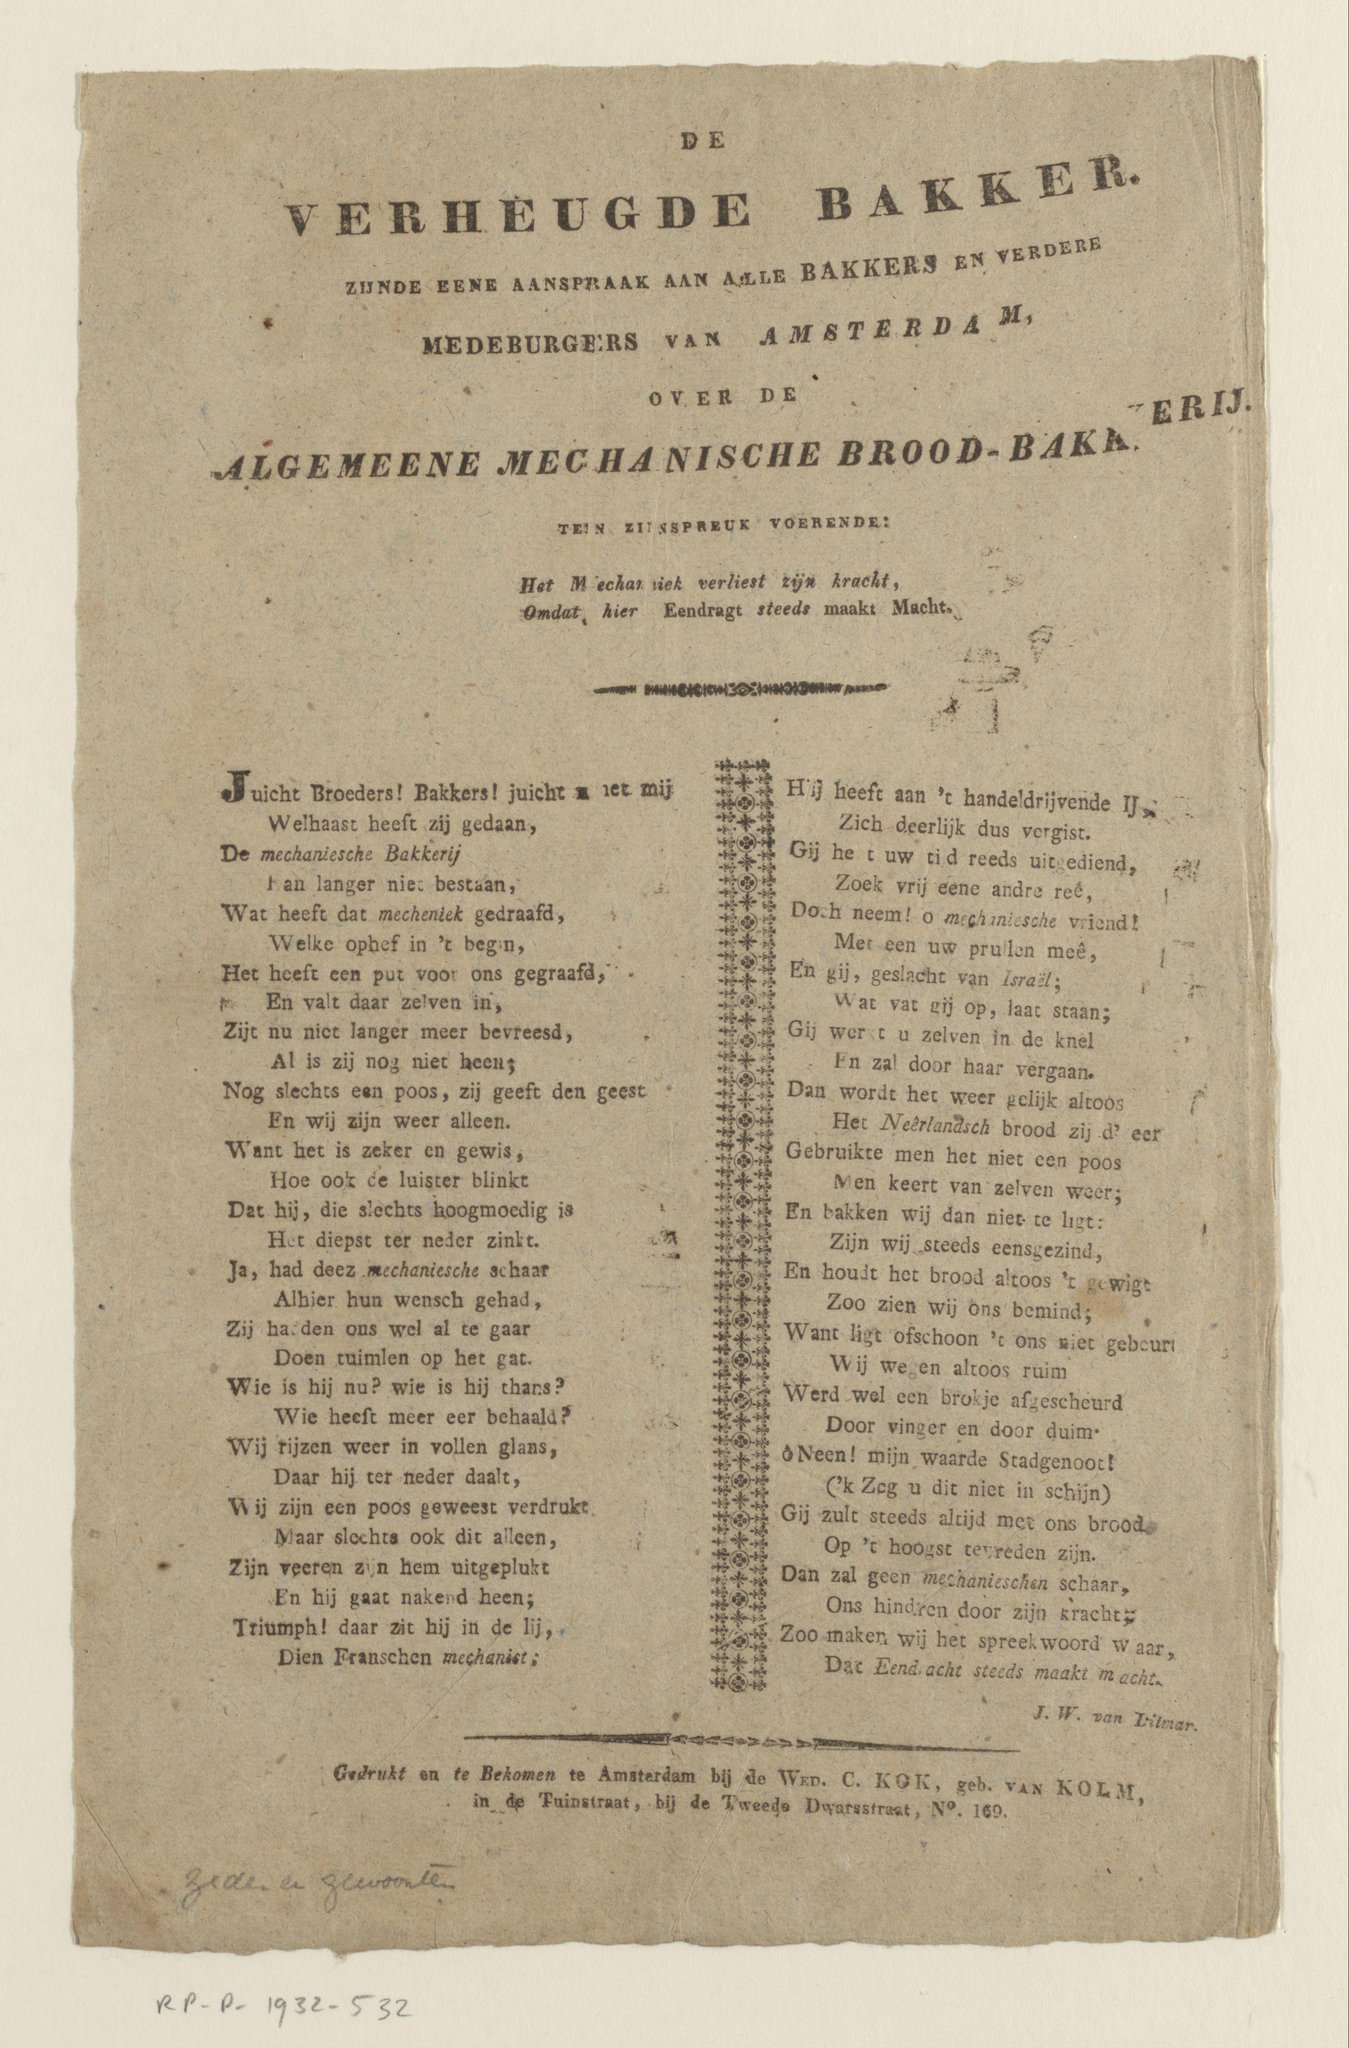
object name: text sheet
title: De Verheugde Bakker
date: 1829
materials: paper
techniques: letterpress printing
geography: amsterdam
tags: baker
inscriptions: collector's mark: Lugt 2233